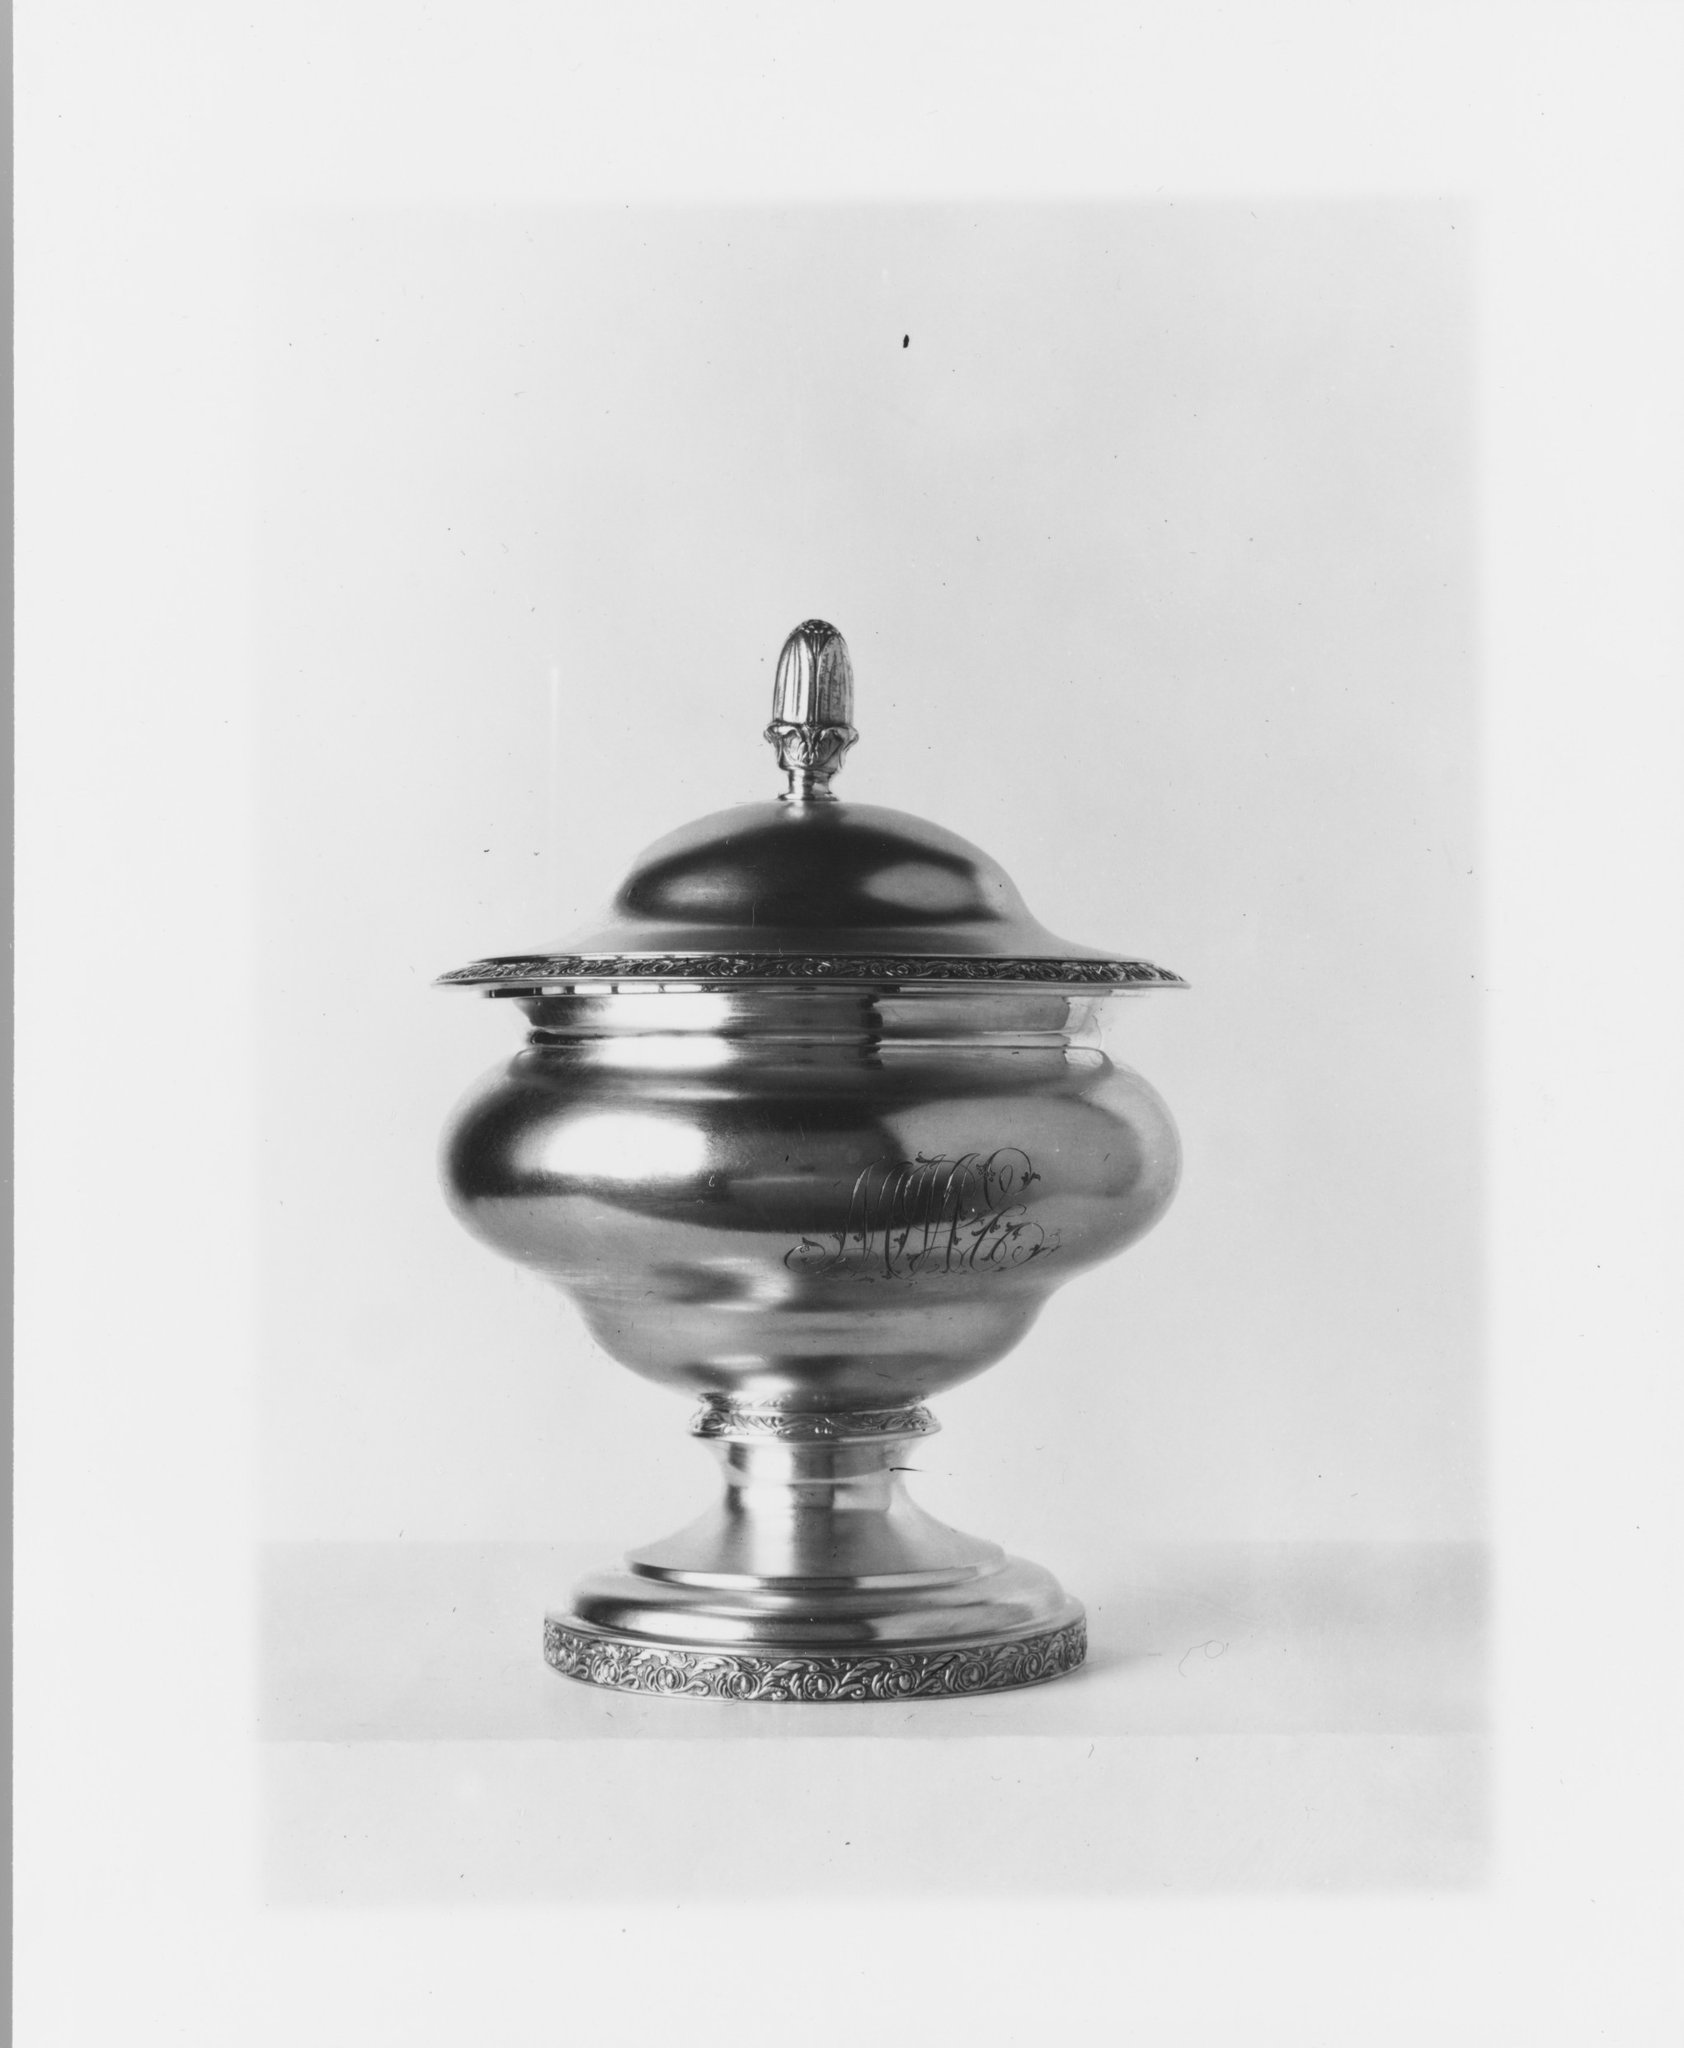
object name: sugar bowl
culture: american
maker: bailey and kitchen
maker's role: retailer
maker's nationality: american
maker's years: 1830-1846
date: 1840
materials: silver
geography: united states